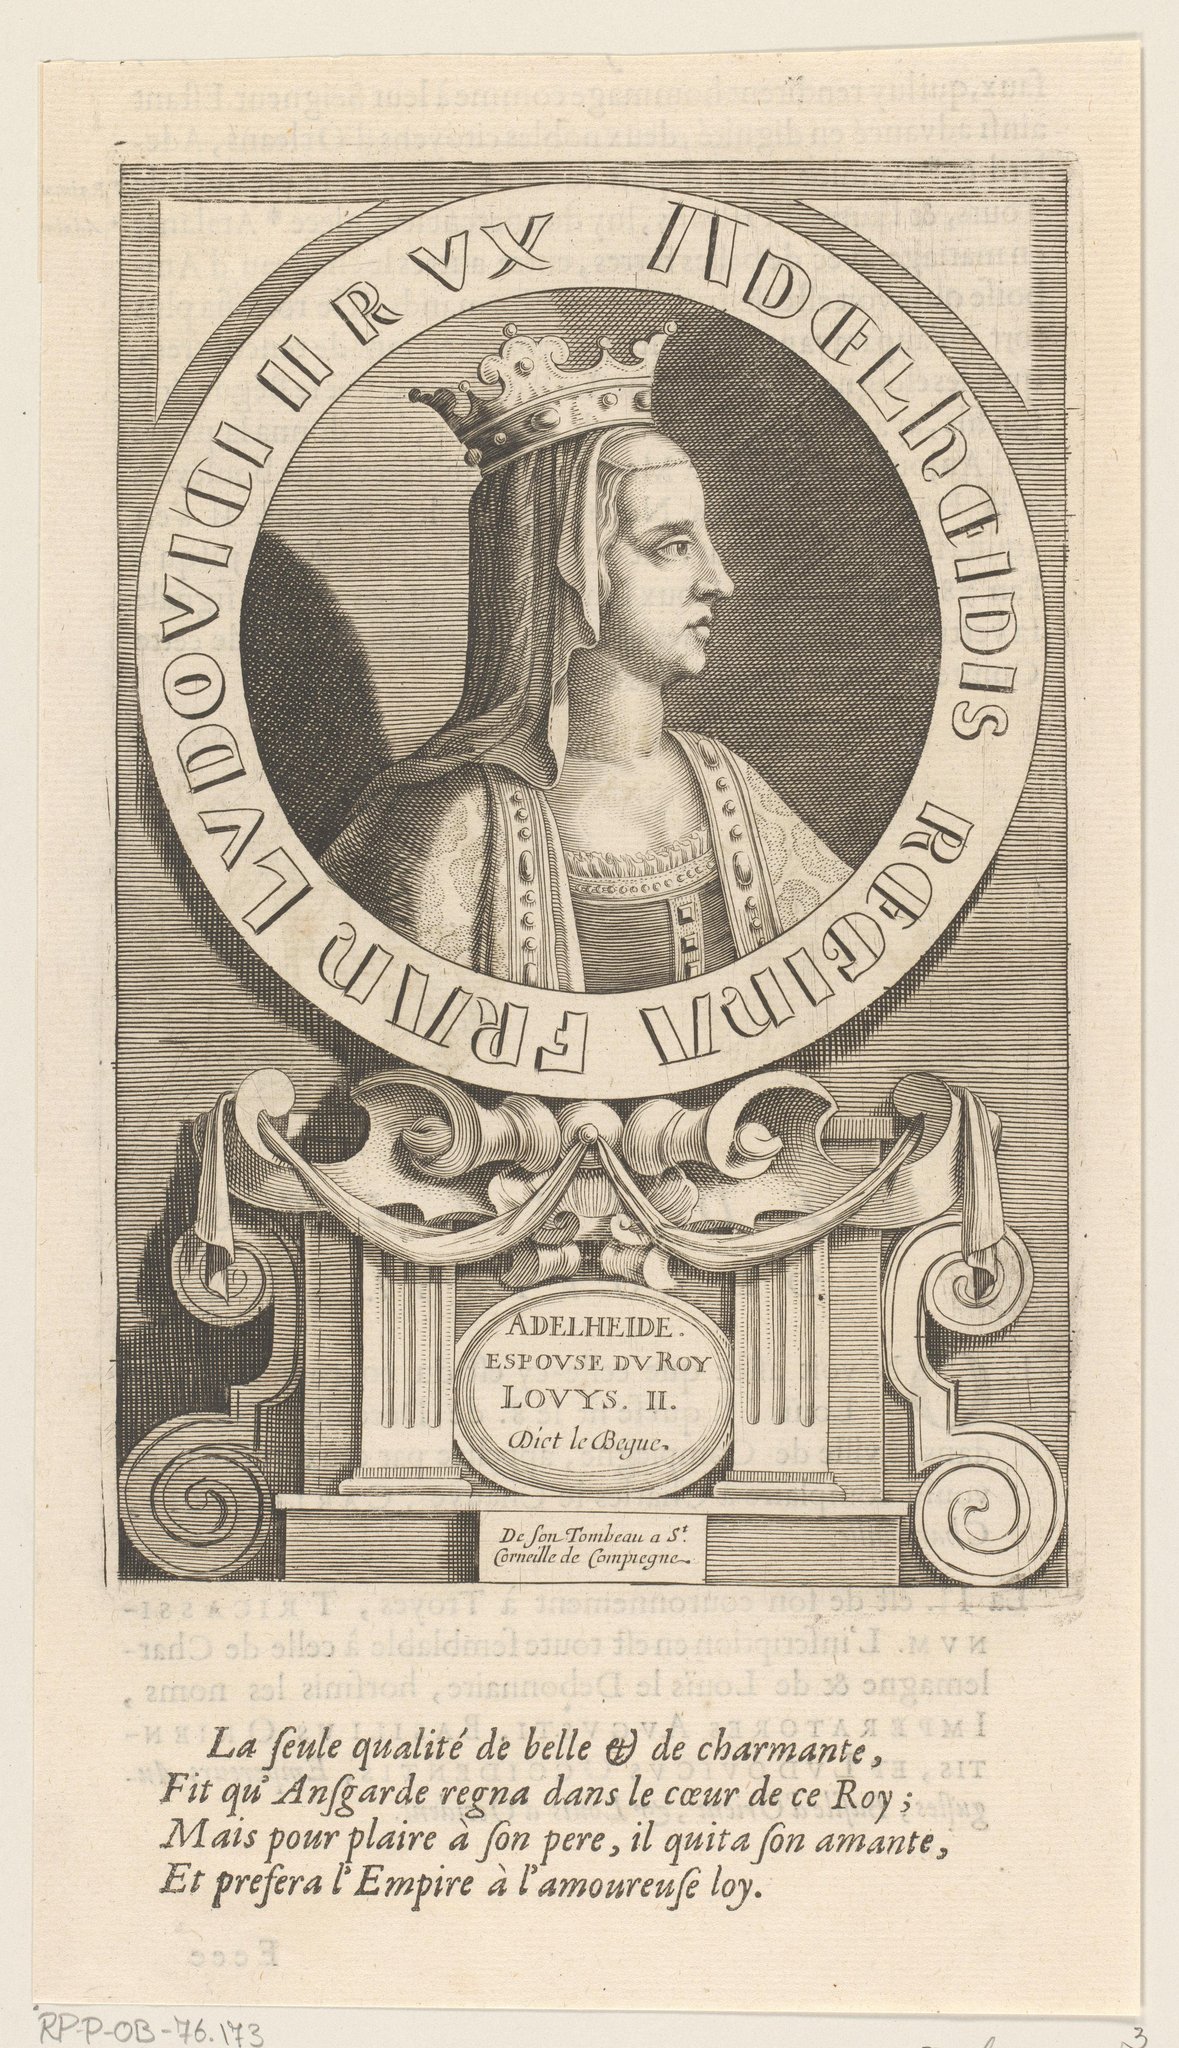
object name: book illustration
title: Portret van Adelheid van Parijs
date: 1635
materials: paper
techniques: engraving, letterpress printing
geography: paris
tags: historical persons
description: Prent uit: Eudes de Mézeray, François. Histoire de France, depuis Faramond jusqu’au regne de Louis le Juste (...). 3 dln. Parijs: Denis Thierry, Jean Guignard en Claude Barbin, 1635, dl. 1. Prent waarschijnlijk voor het eerst verschenen in: Bie, Jacques de. Les vrais portraits des rois de France (...). Parijs: Jacques de Bie en Pierre Rocolet, 1634. Prent ook gebruikt in latere publicaties.